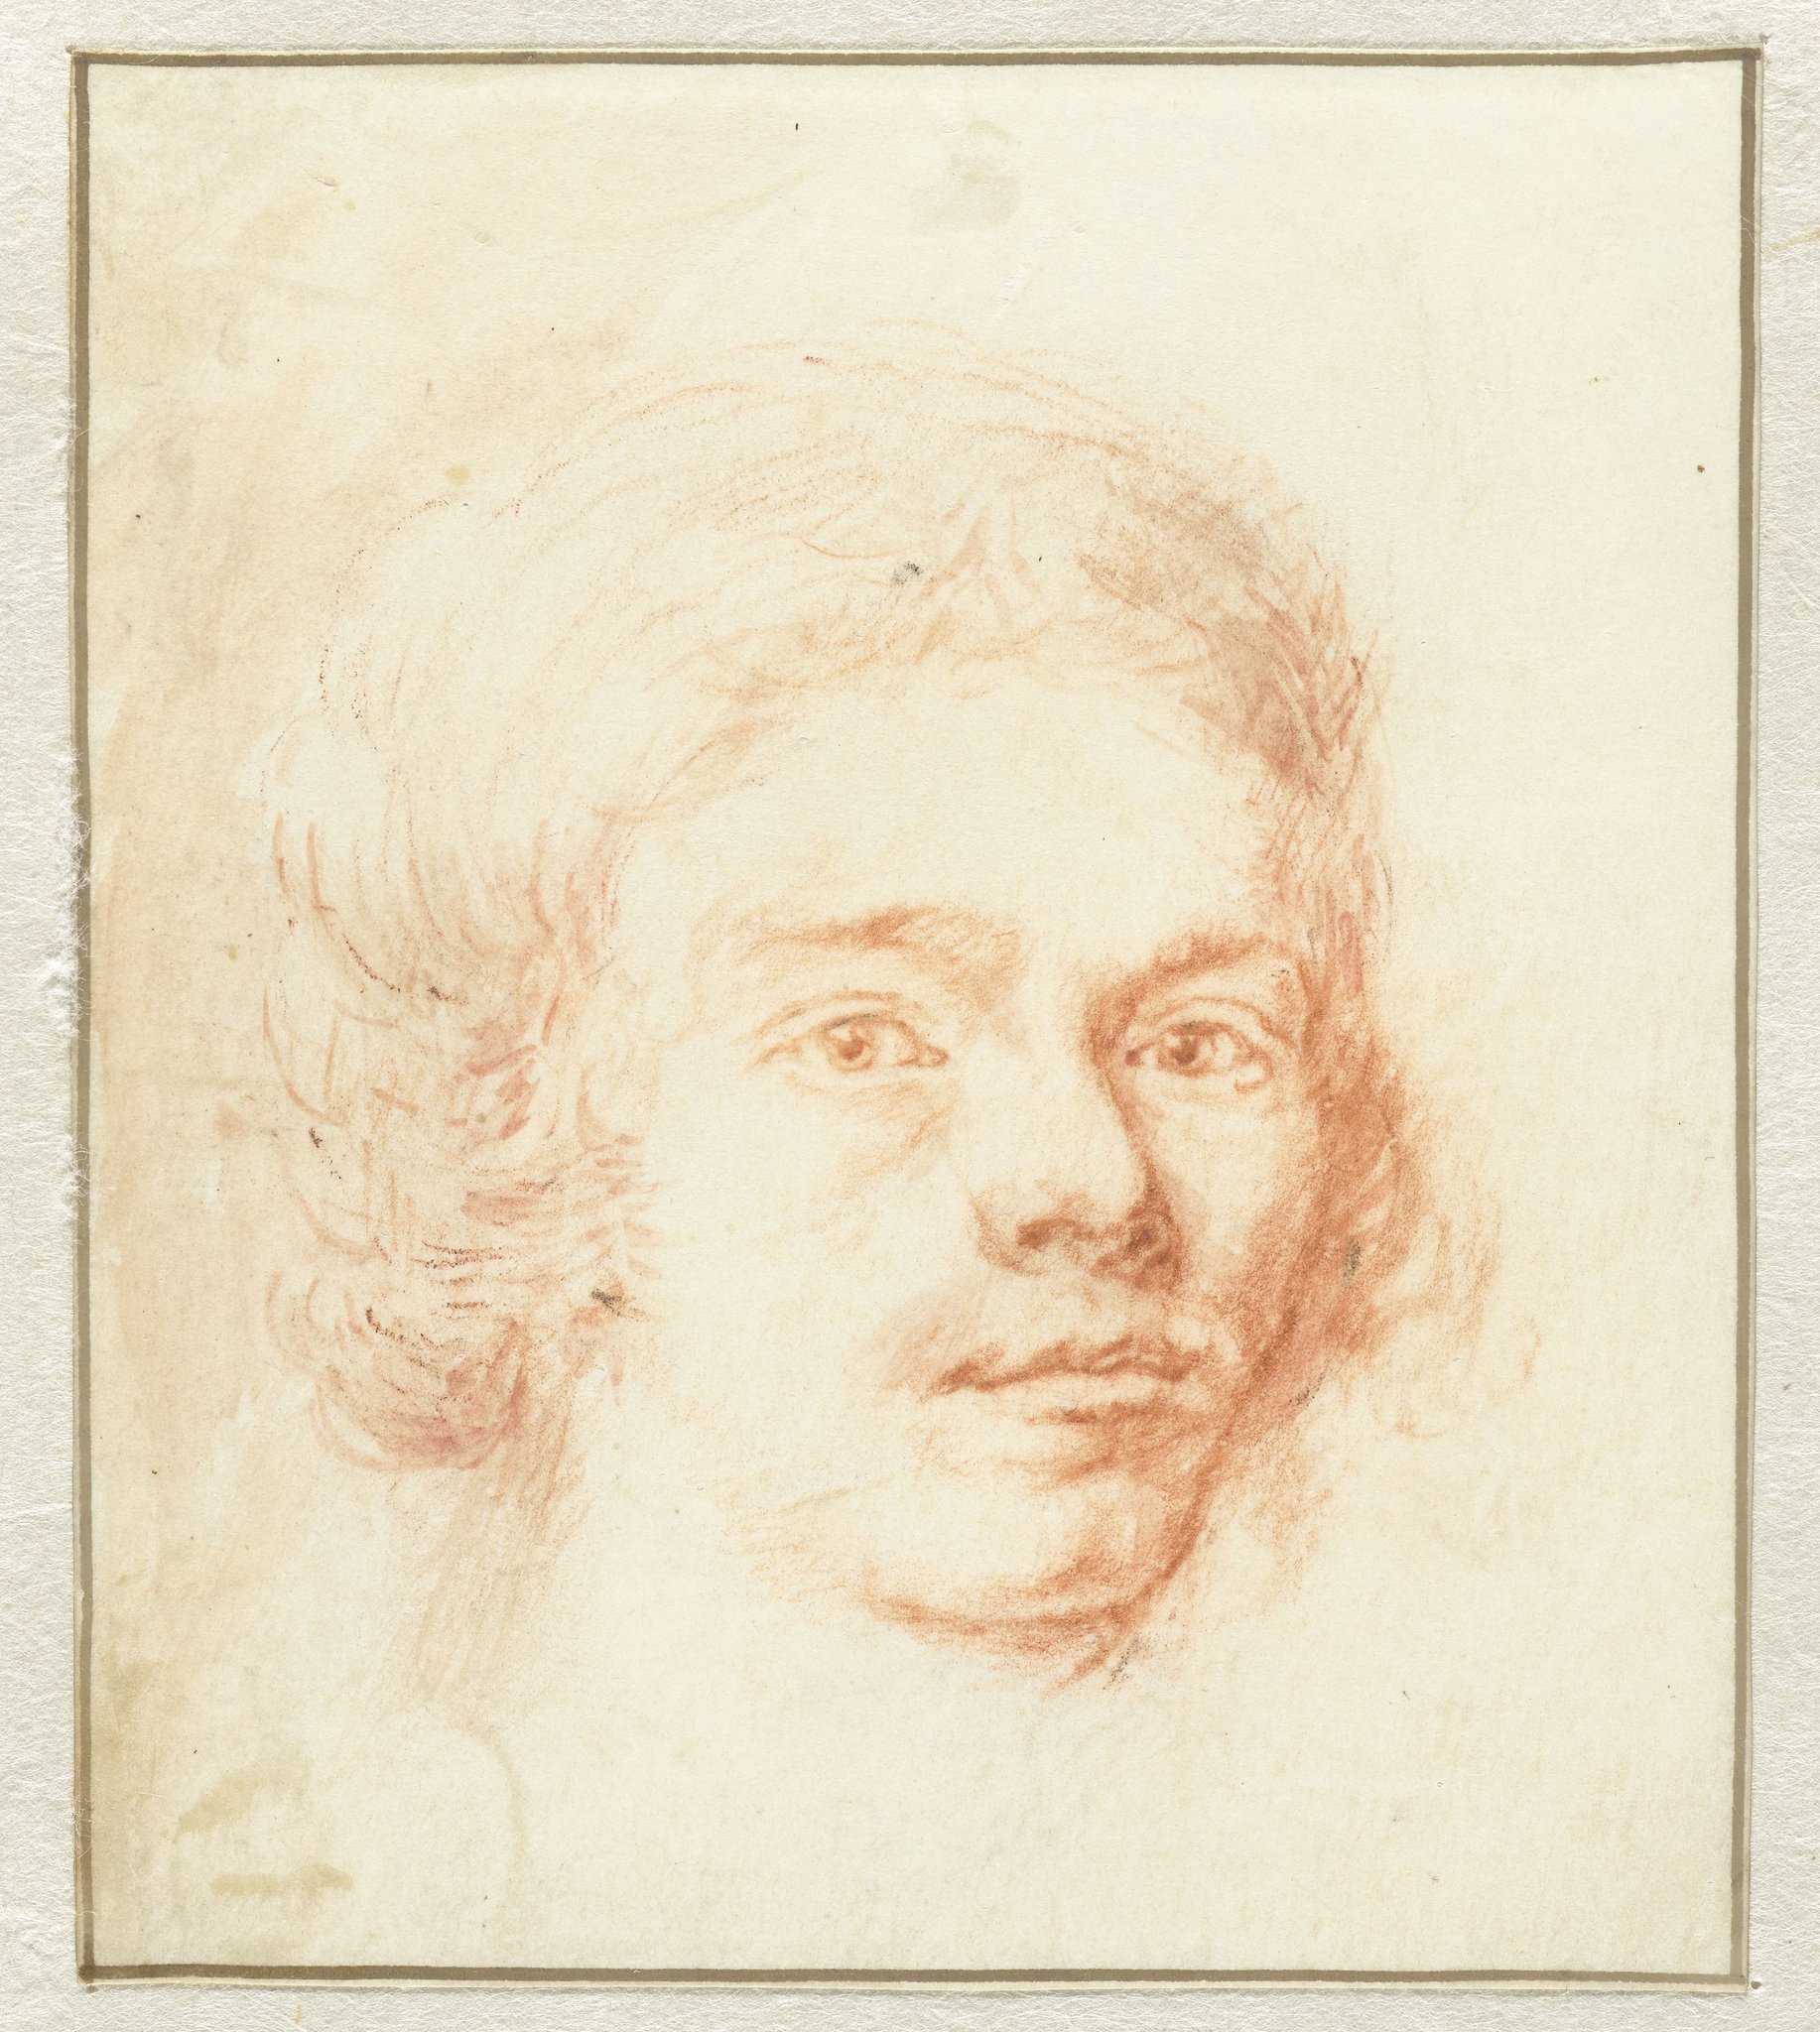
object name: drawing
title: Jongenskop met kort haar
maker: Anonymous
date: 1600-1699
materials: chalk, parchment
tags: head (human), boy (child between toddler and youth)